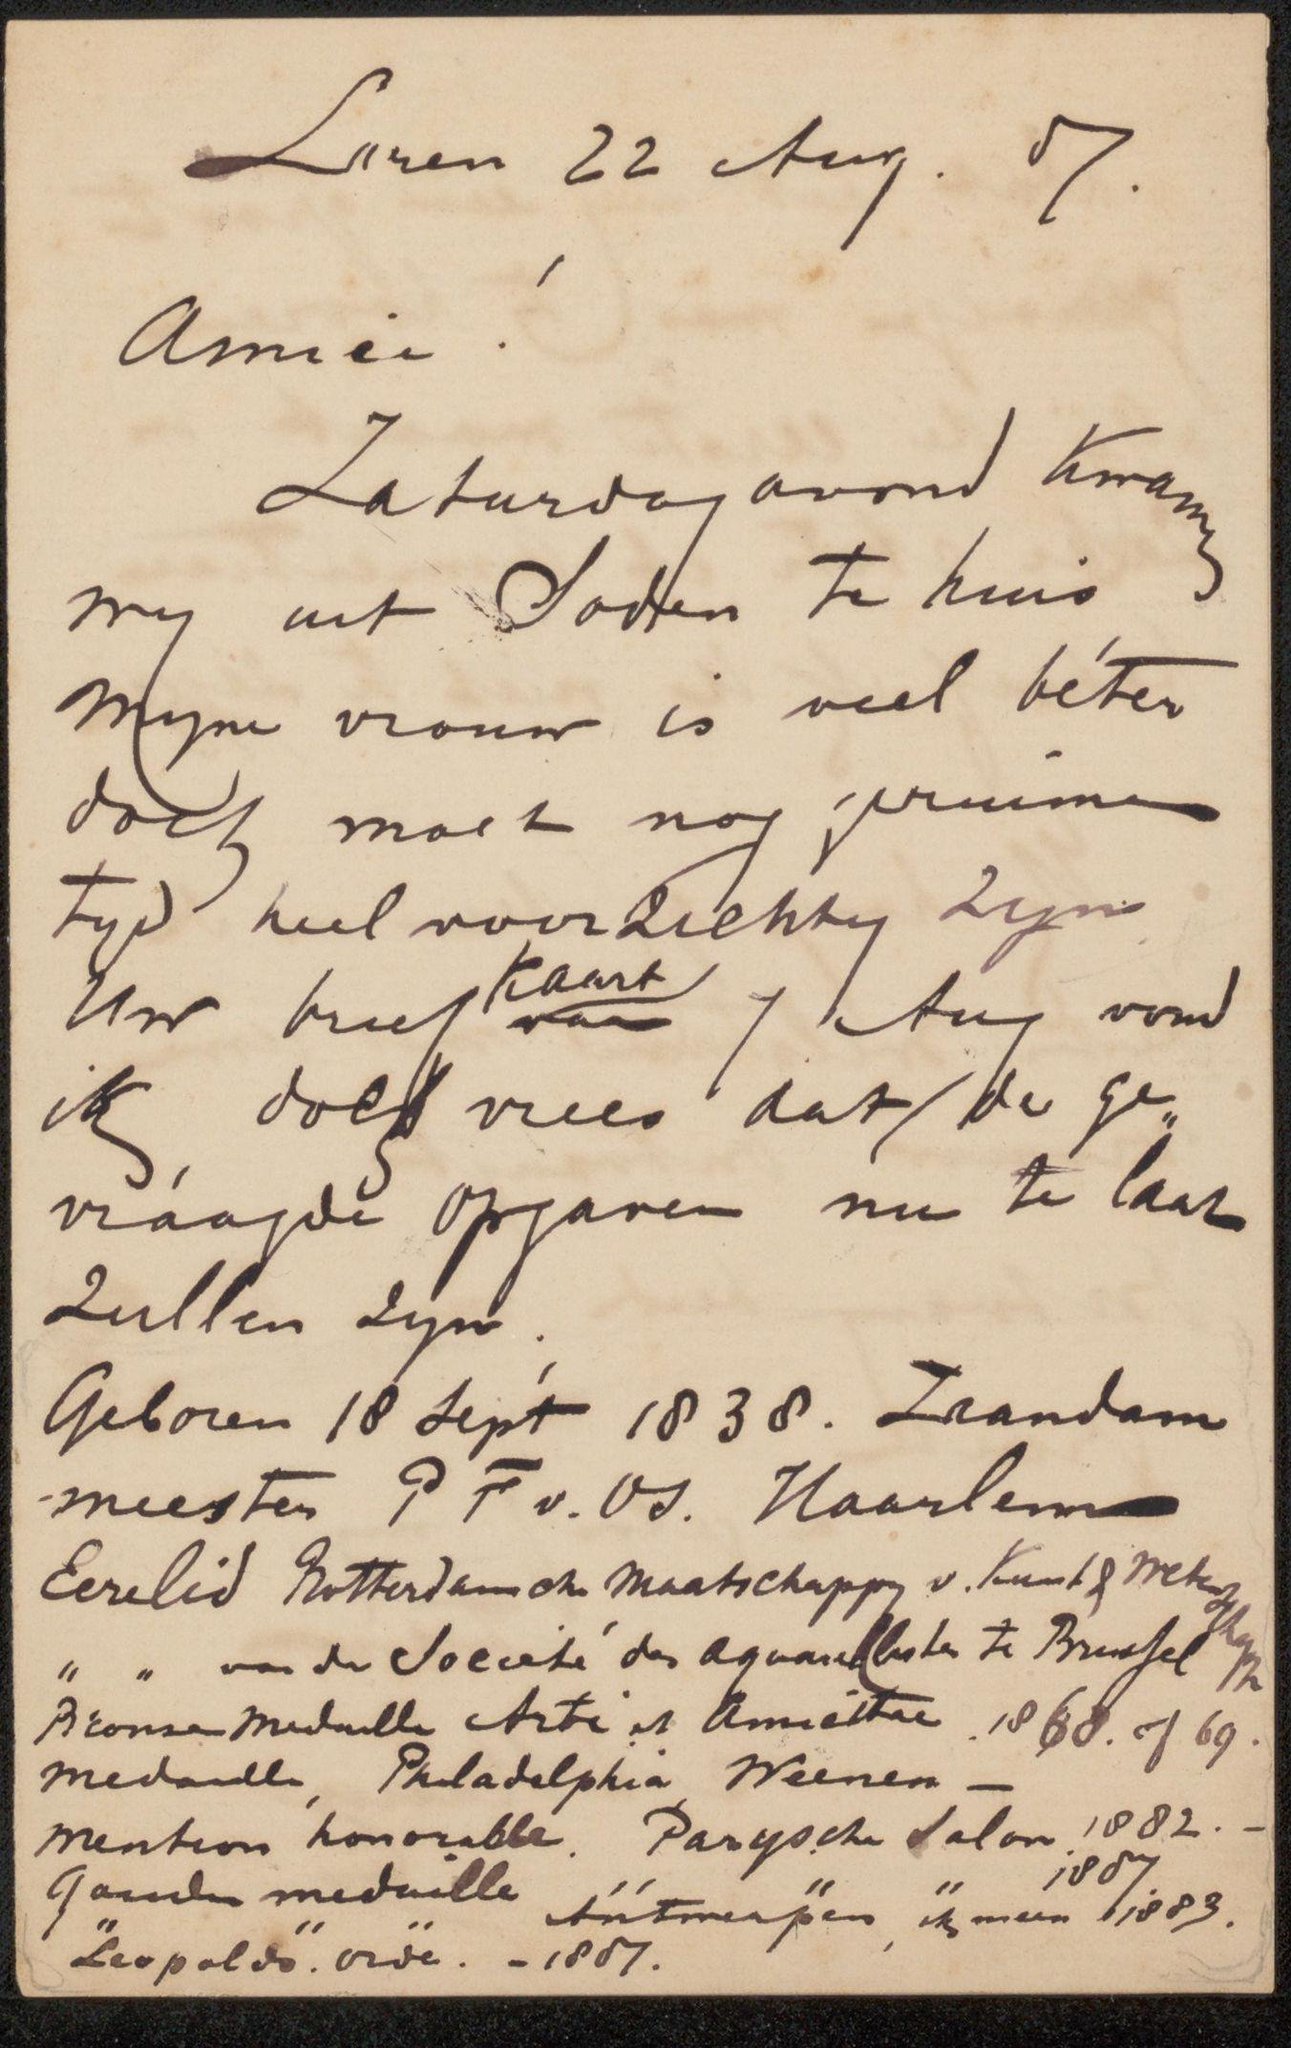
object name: letter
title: Brief aan Philip Zilcken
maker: anton mauve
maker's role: draughtsman, painter, print maker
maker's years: 1838-1888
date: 1887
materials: ink, paper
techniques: pen, writing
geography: laren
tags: amsterdam, haarlem, print maker, pieter frederik van os, painter, draughtsman, philip zilcken, family life, temporary exhibition, 'salon', antwerp, vienna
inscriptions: collector's mark: ‘RPK’